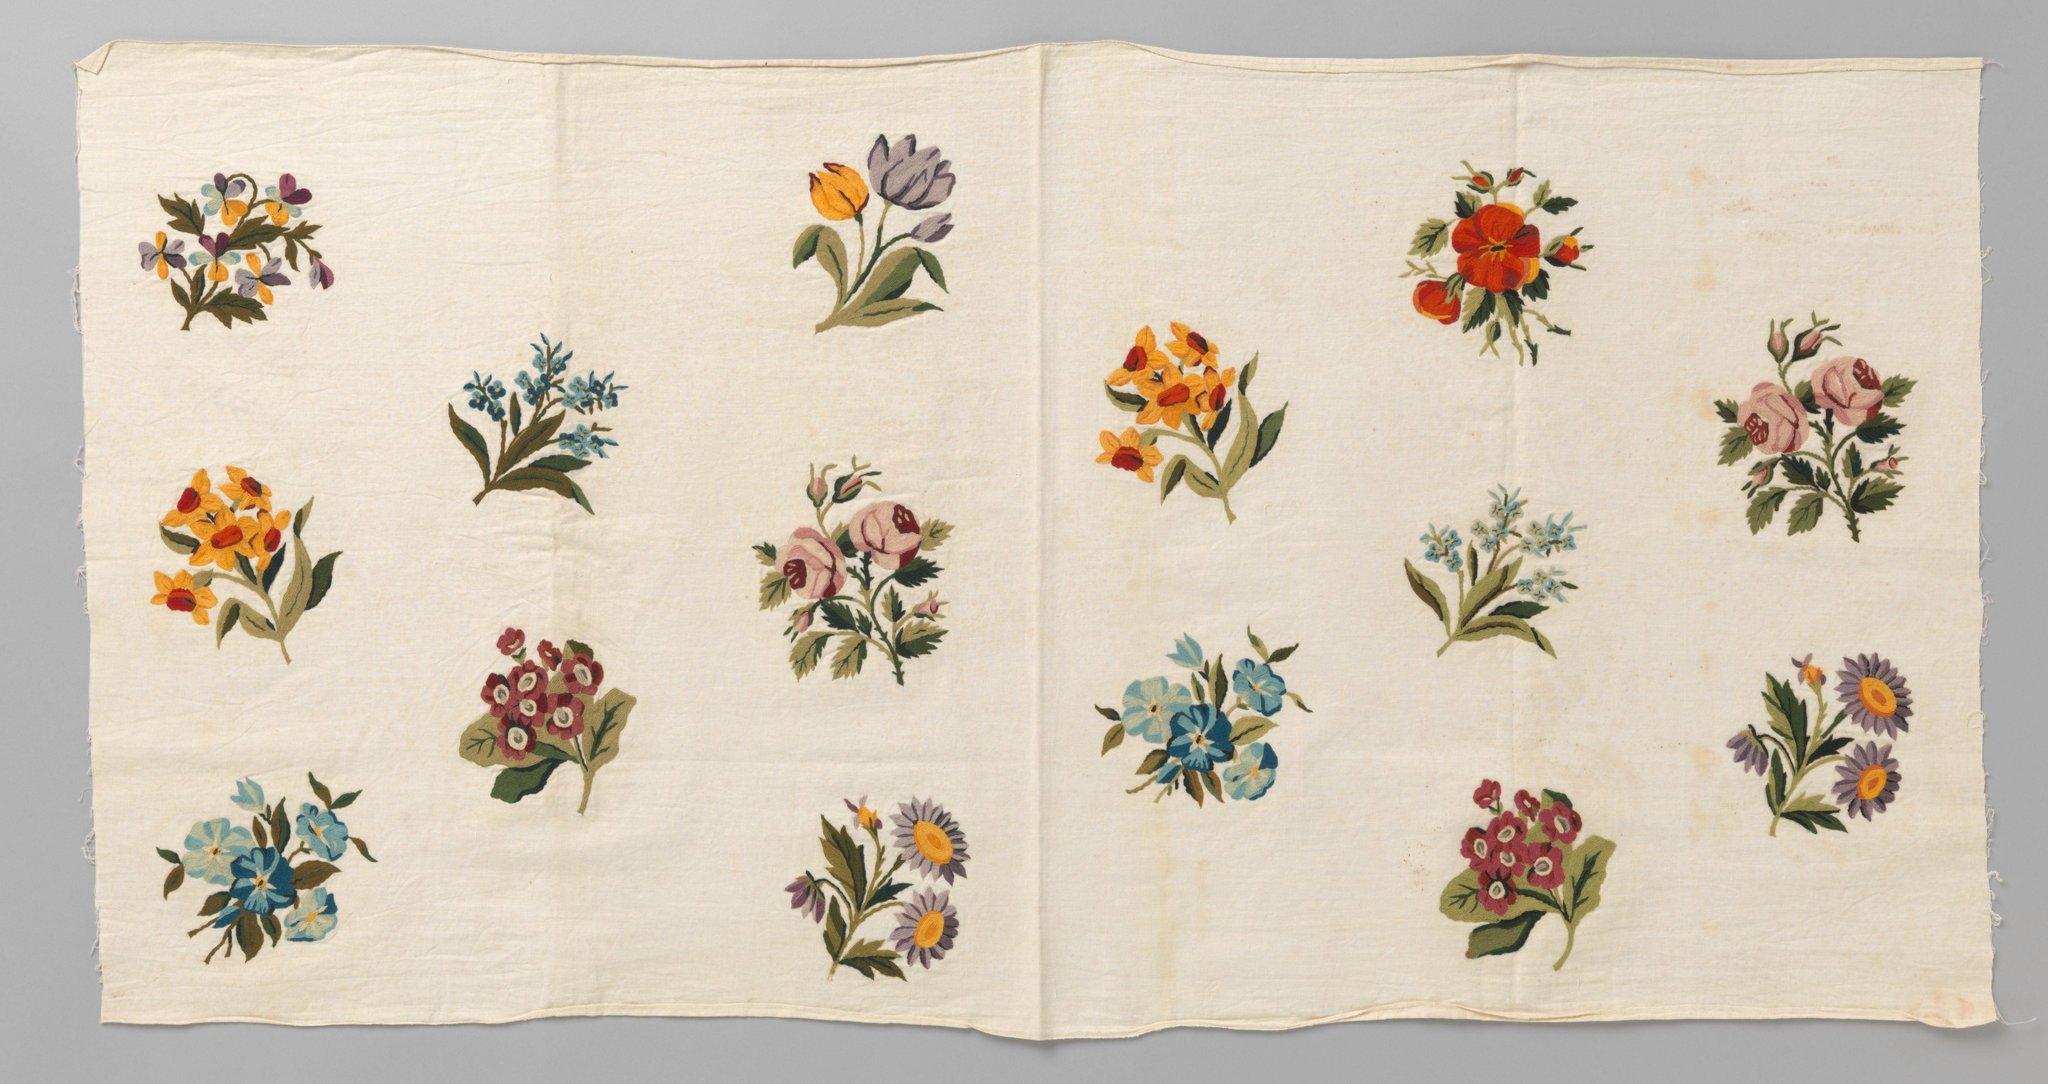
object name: bekledingsstof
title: Metrage bekledingsstof met borduurwerk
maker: Anonymous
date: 1850-1949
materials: cotton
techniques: weave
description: Metrage bekledingsstof, geborduurd met kleurige bloemtakken.